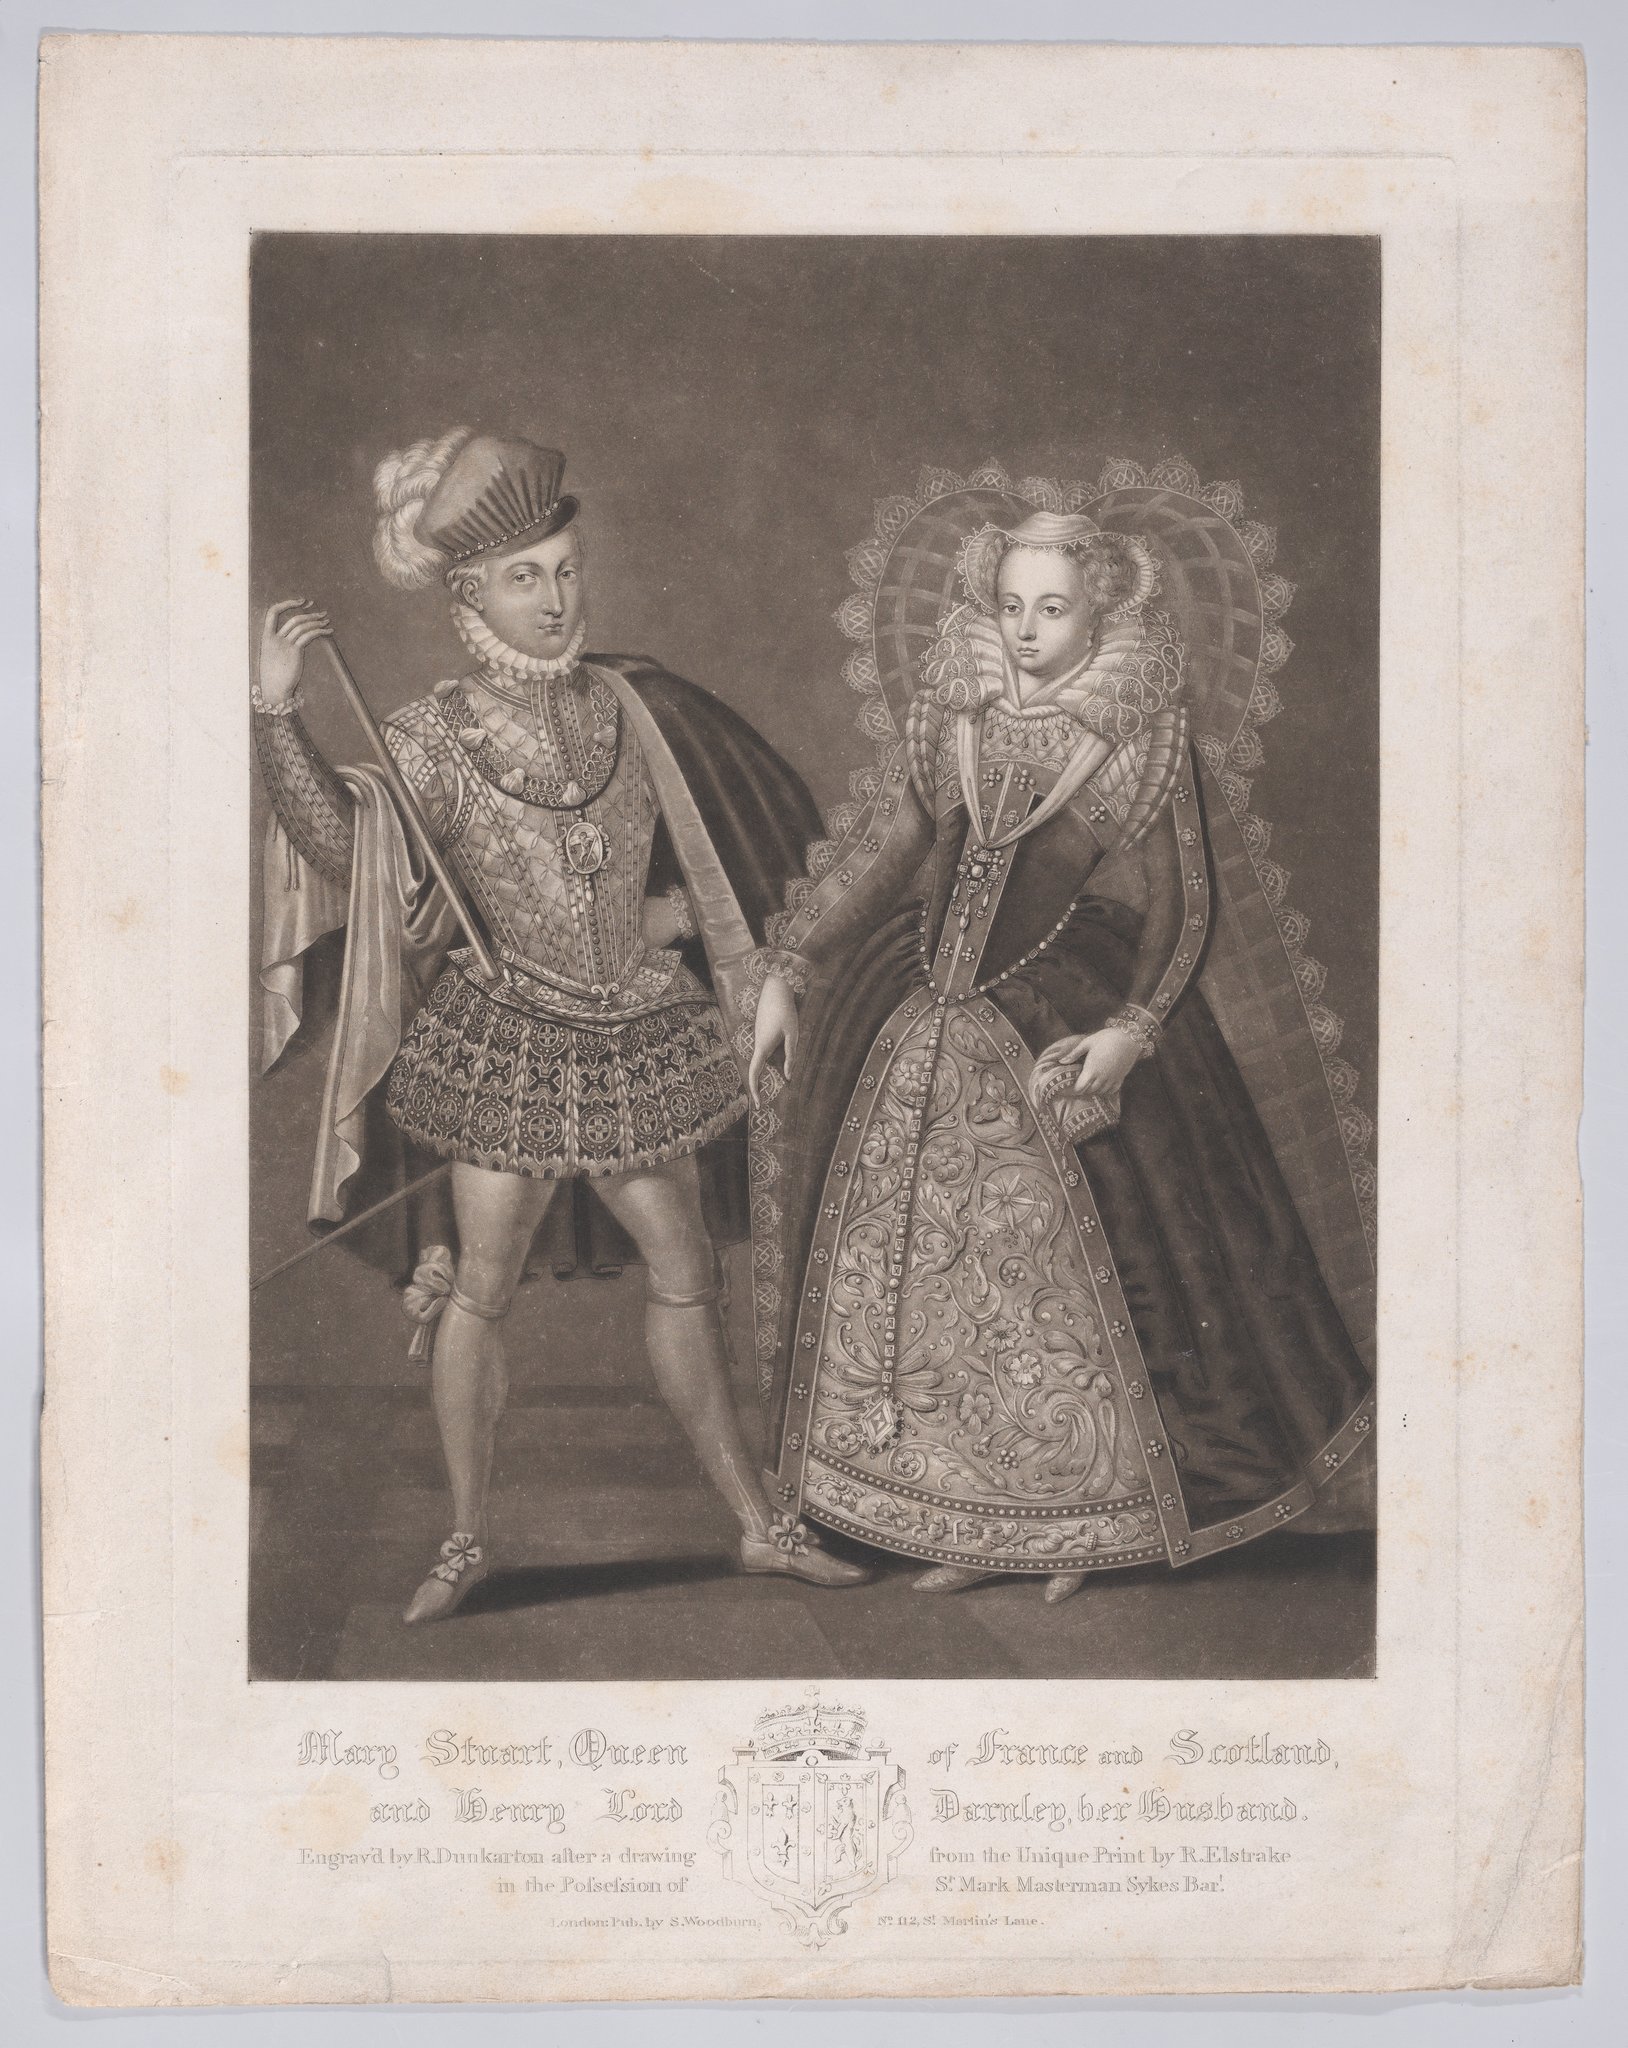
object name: print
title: Mary, Queen of Scots and Lord Darnley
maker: robert dunkarton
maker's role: artist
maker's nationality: british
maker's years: 1744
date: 1816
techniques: mezzotint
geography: england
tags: queens,portraits,women,mary queen of scots